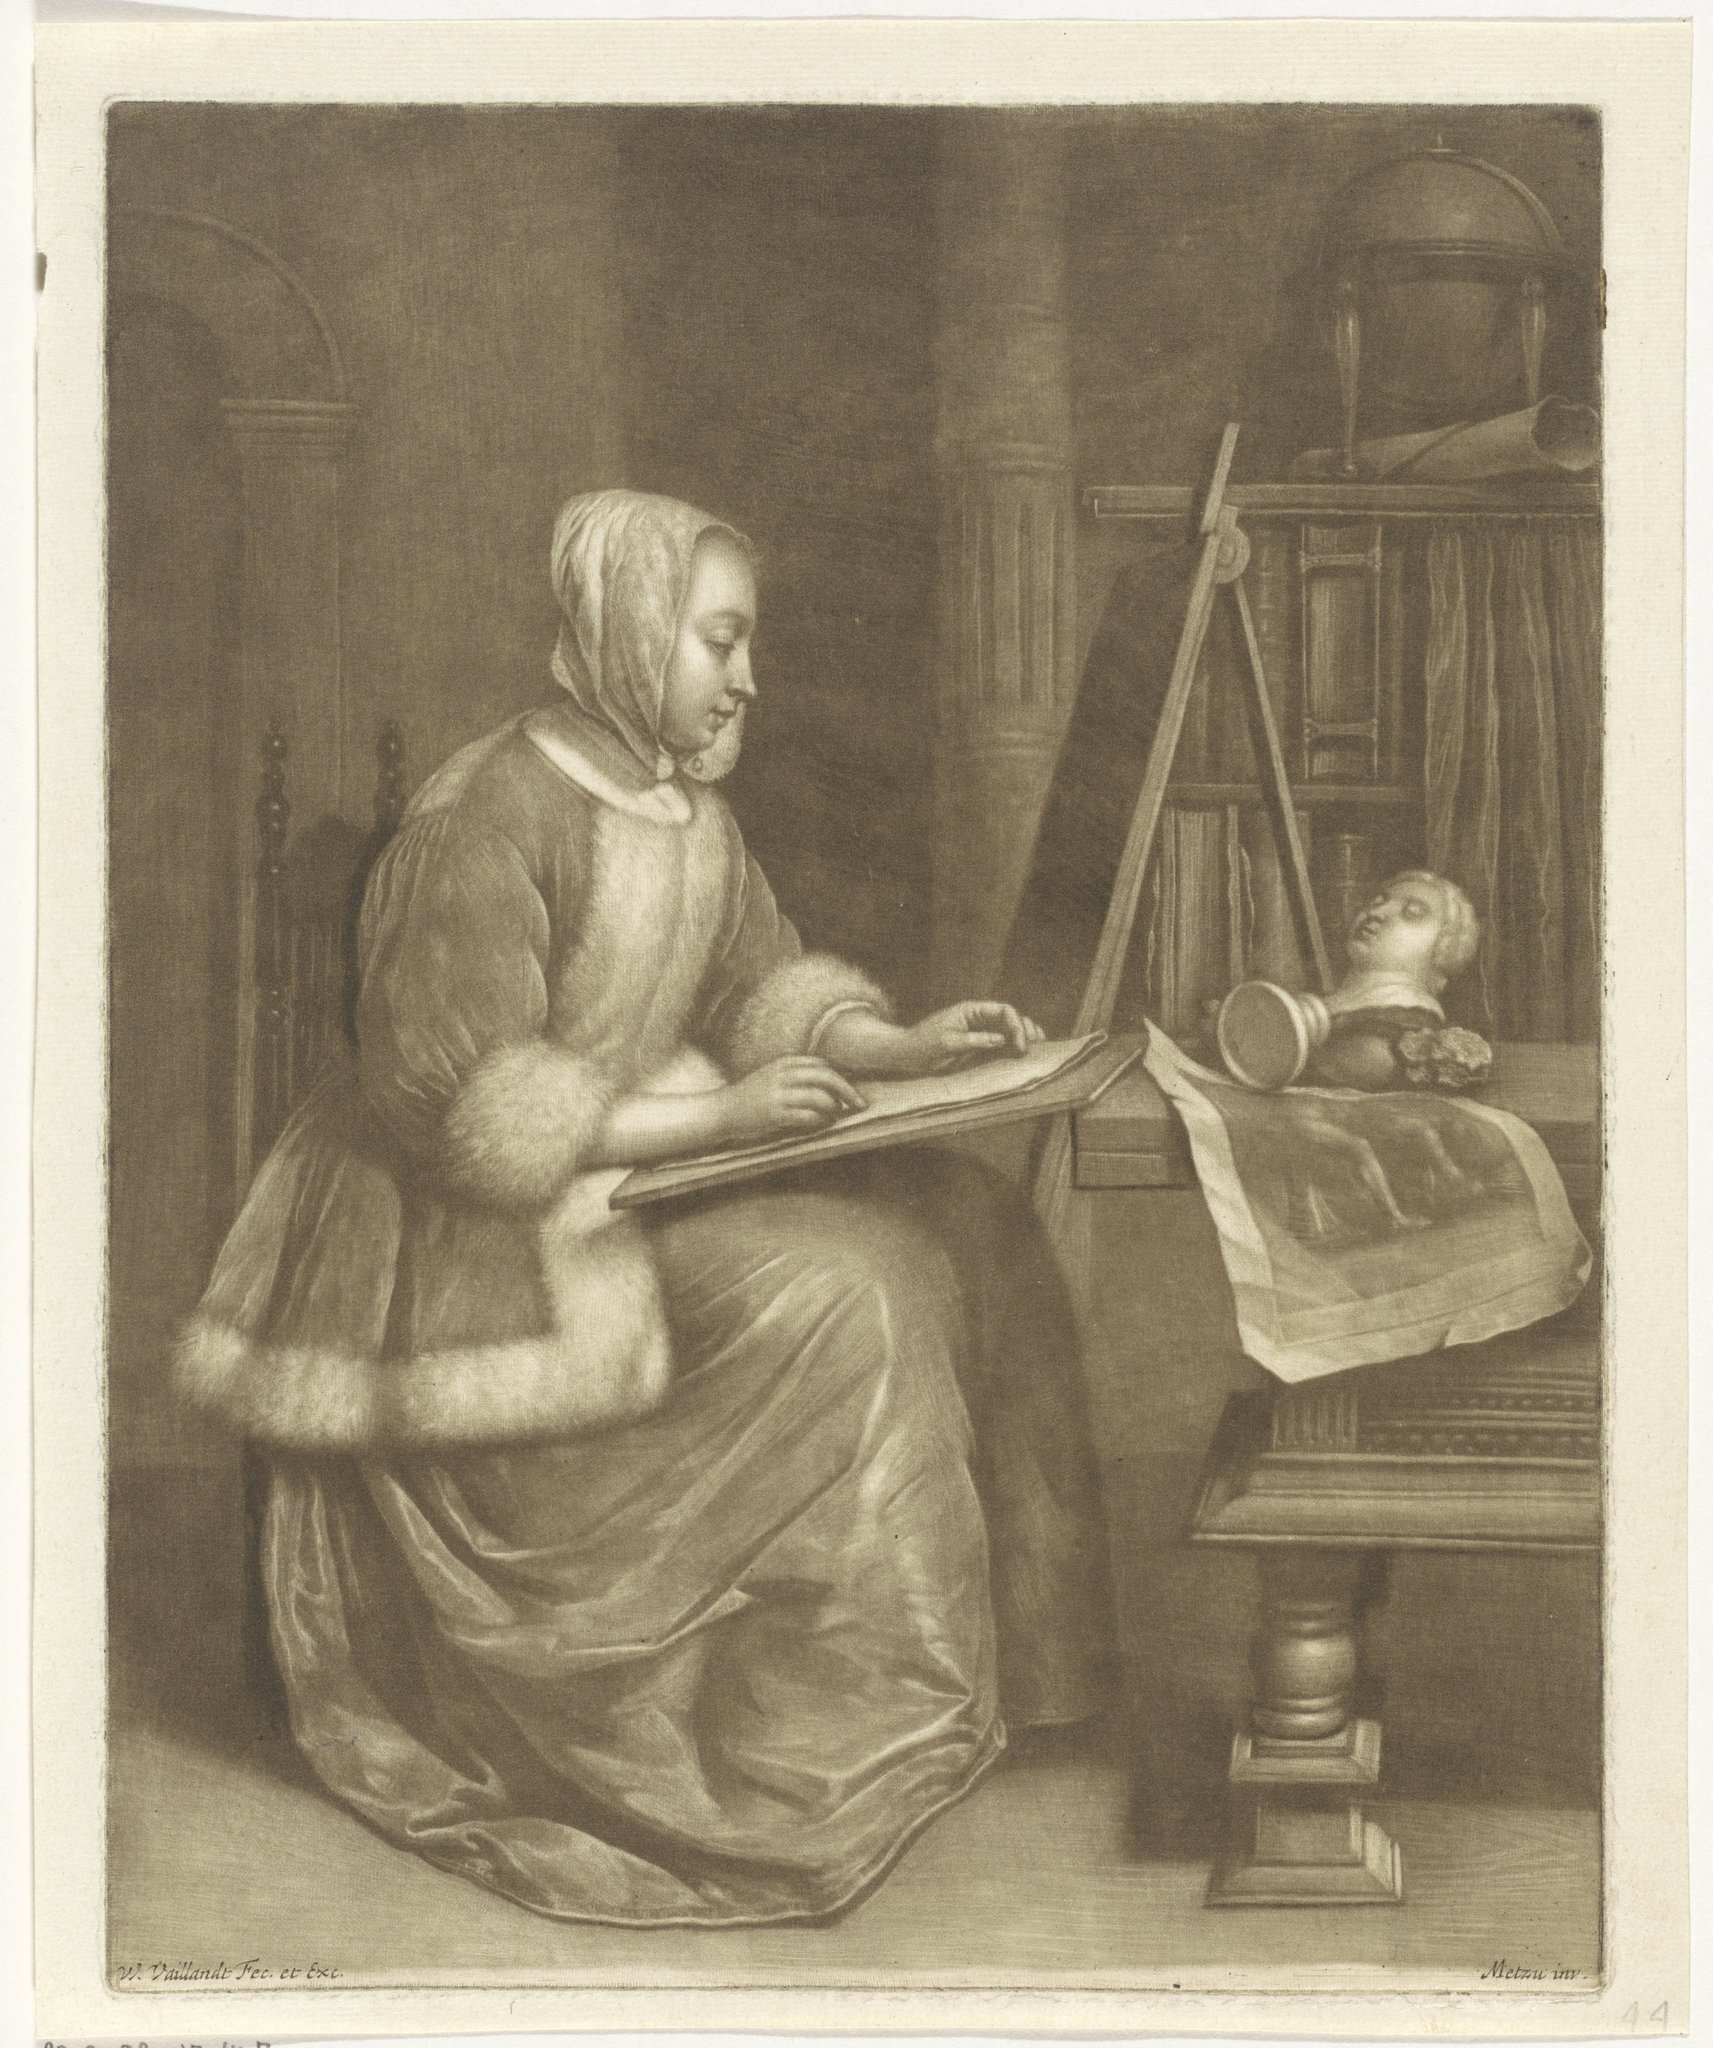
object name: print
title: Tekenende vrouw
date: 1658-1677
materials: paper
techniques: mezzotint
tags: print, e.g.: engraving, etching, lithograph, draughtsman at work, easel, globe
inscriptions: collector's mark: Lugt 240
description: In een vertrek zit een jonge vrouw te tekenen aan een tafel. Voor haar liggen een prent en een buste. Op de achtergrond een boekenkast waarop een globe.